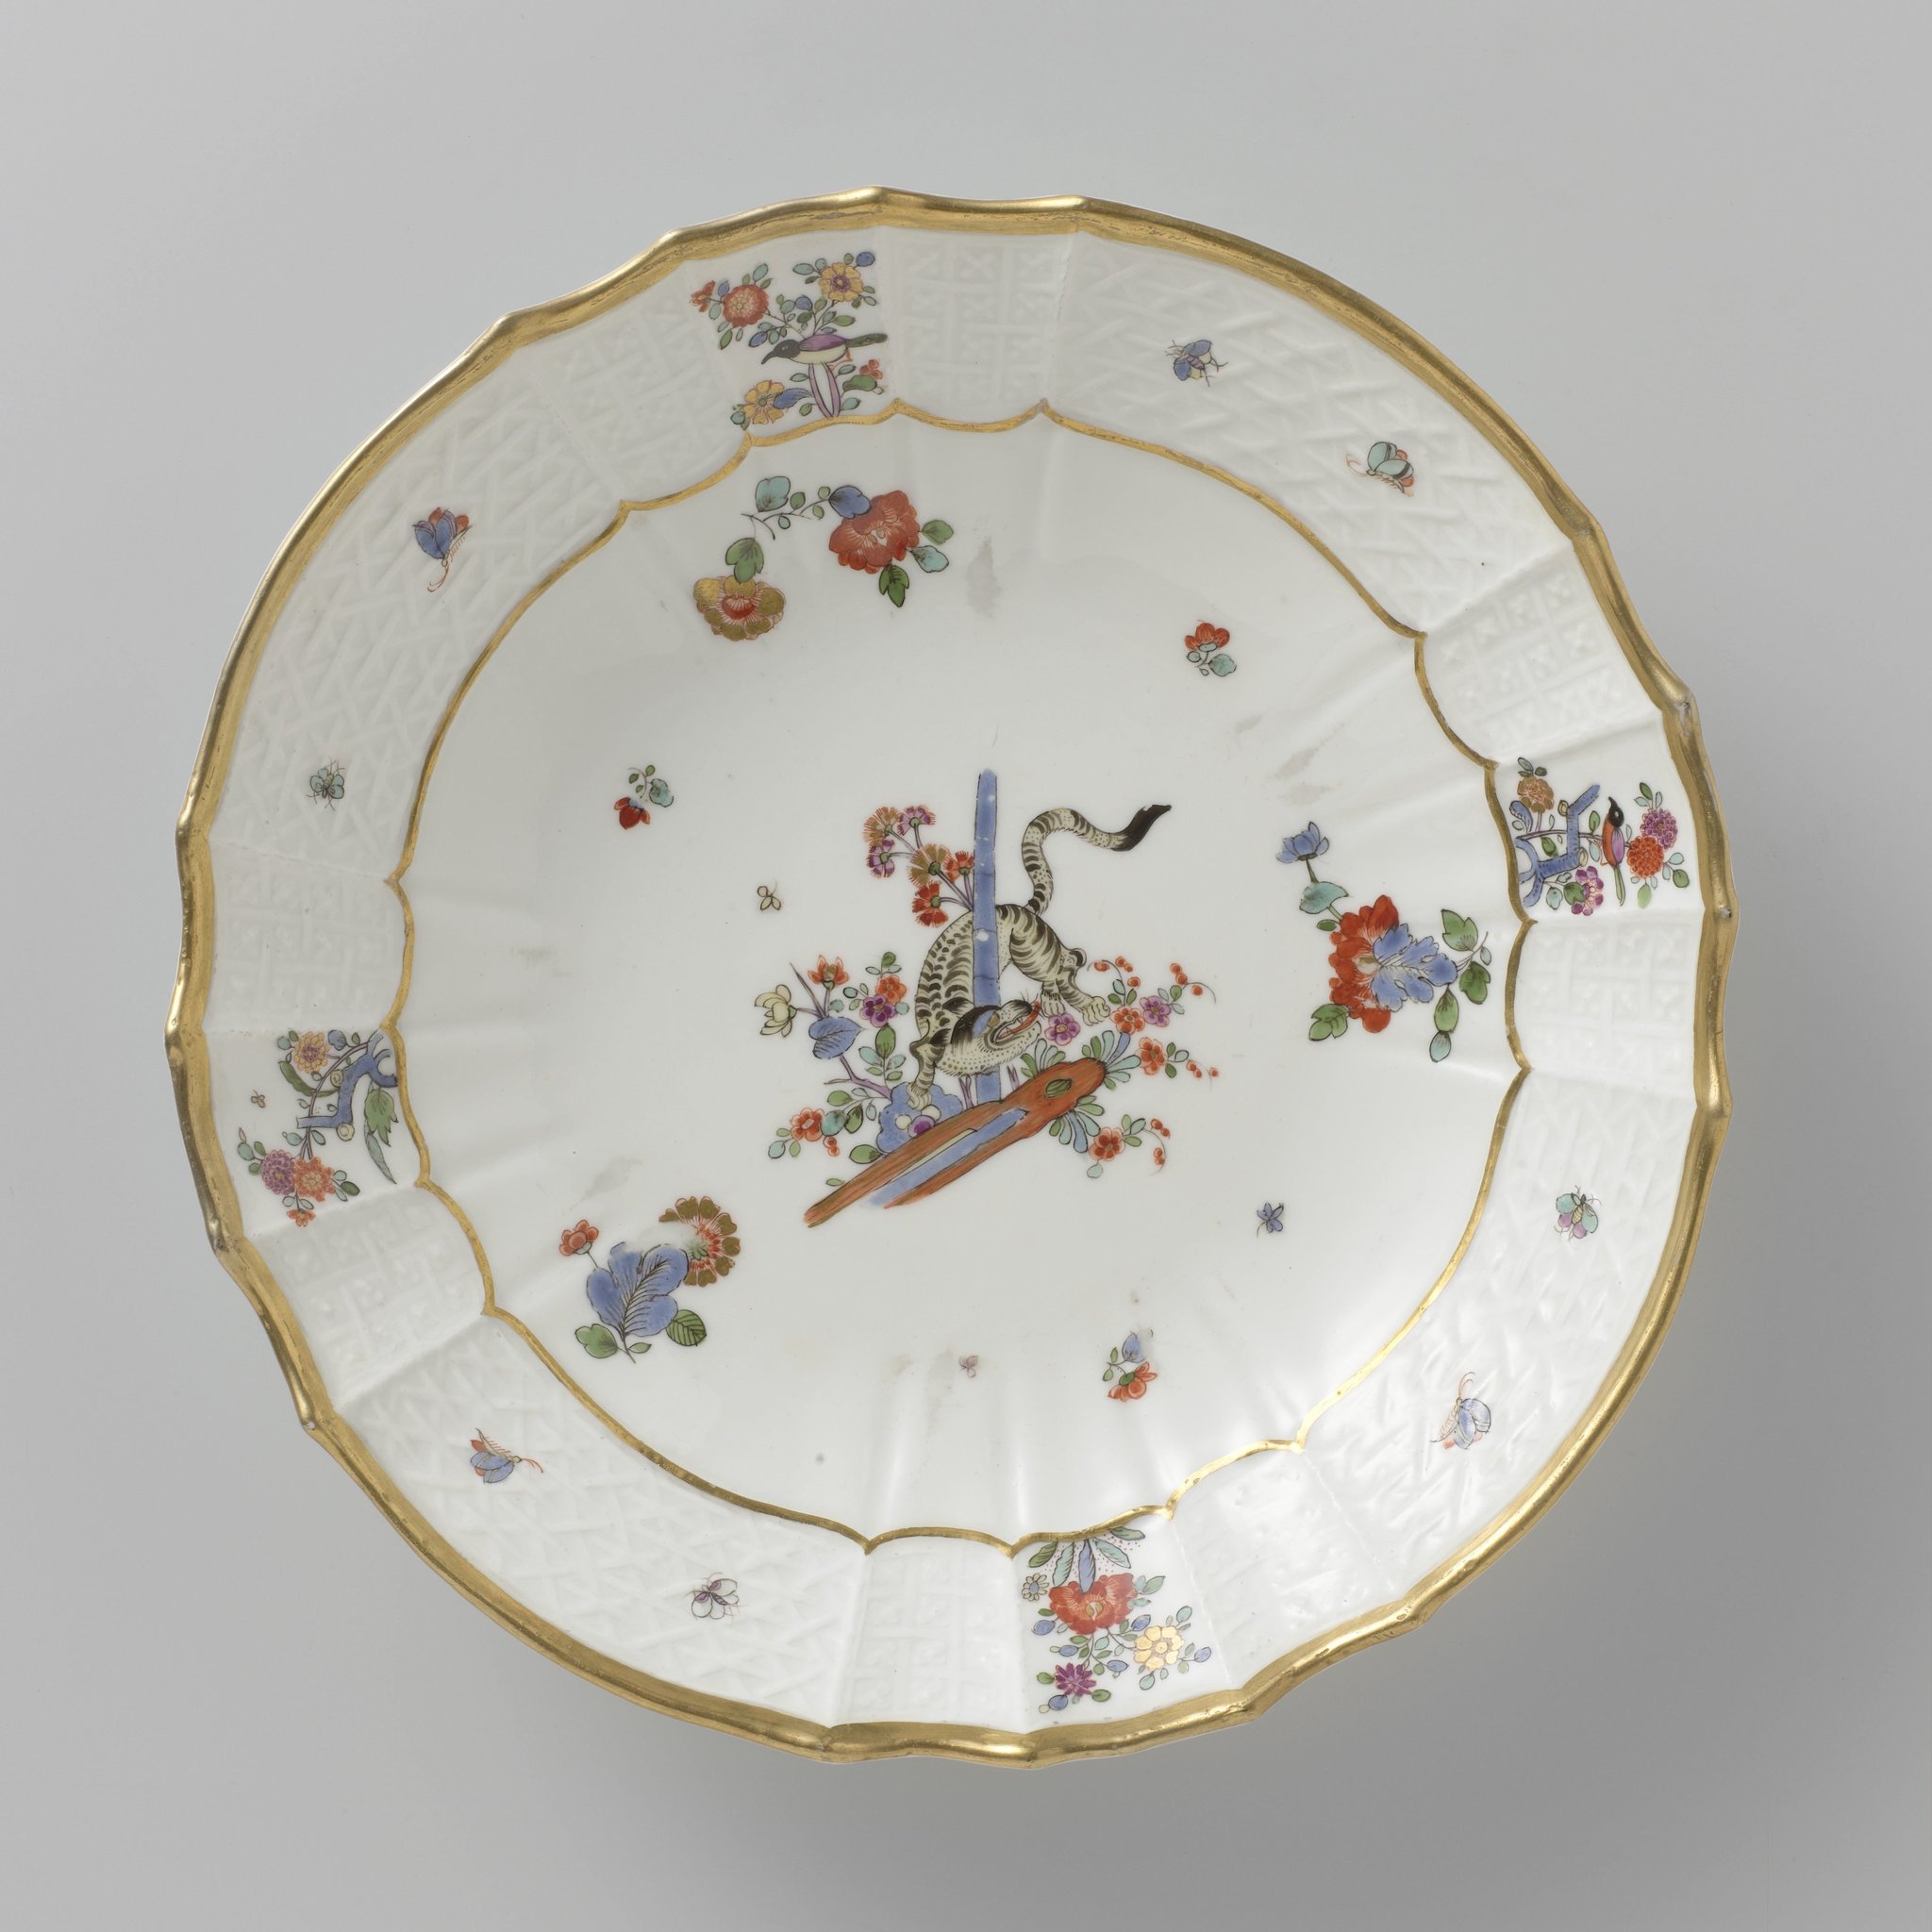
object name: platter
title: Schotel, veelkleurig beschilderd met een Kakiemon-decor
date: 1740-1745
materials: porcelain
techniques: painted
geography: meissen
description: Ronde schotel van beschilderd porselein. De schotel heeft een geribde en geschulpte rand. De schotel is beschilderd met een tijger om een bamboestengel, gestrooide Indianische Blumen, vlinders en takken met vogels. De rand is versierd met het 'Altbrandenstein'-patroon. De schotel is gemerkt.